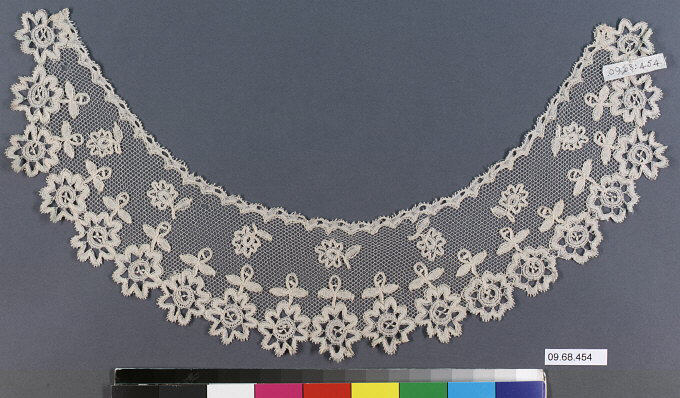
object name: collar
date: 1801-1900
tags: flowers